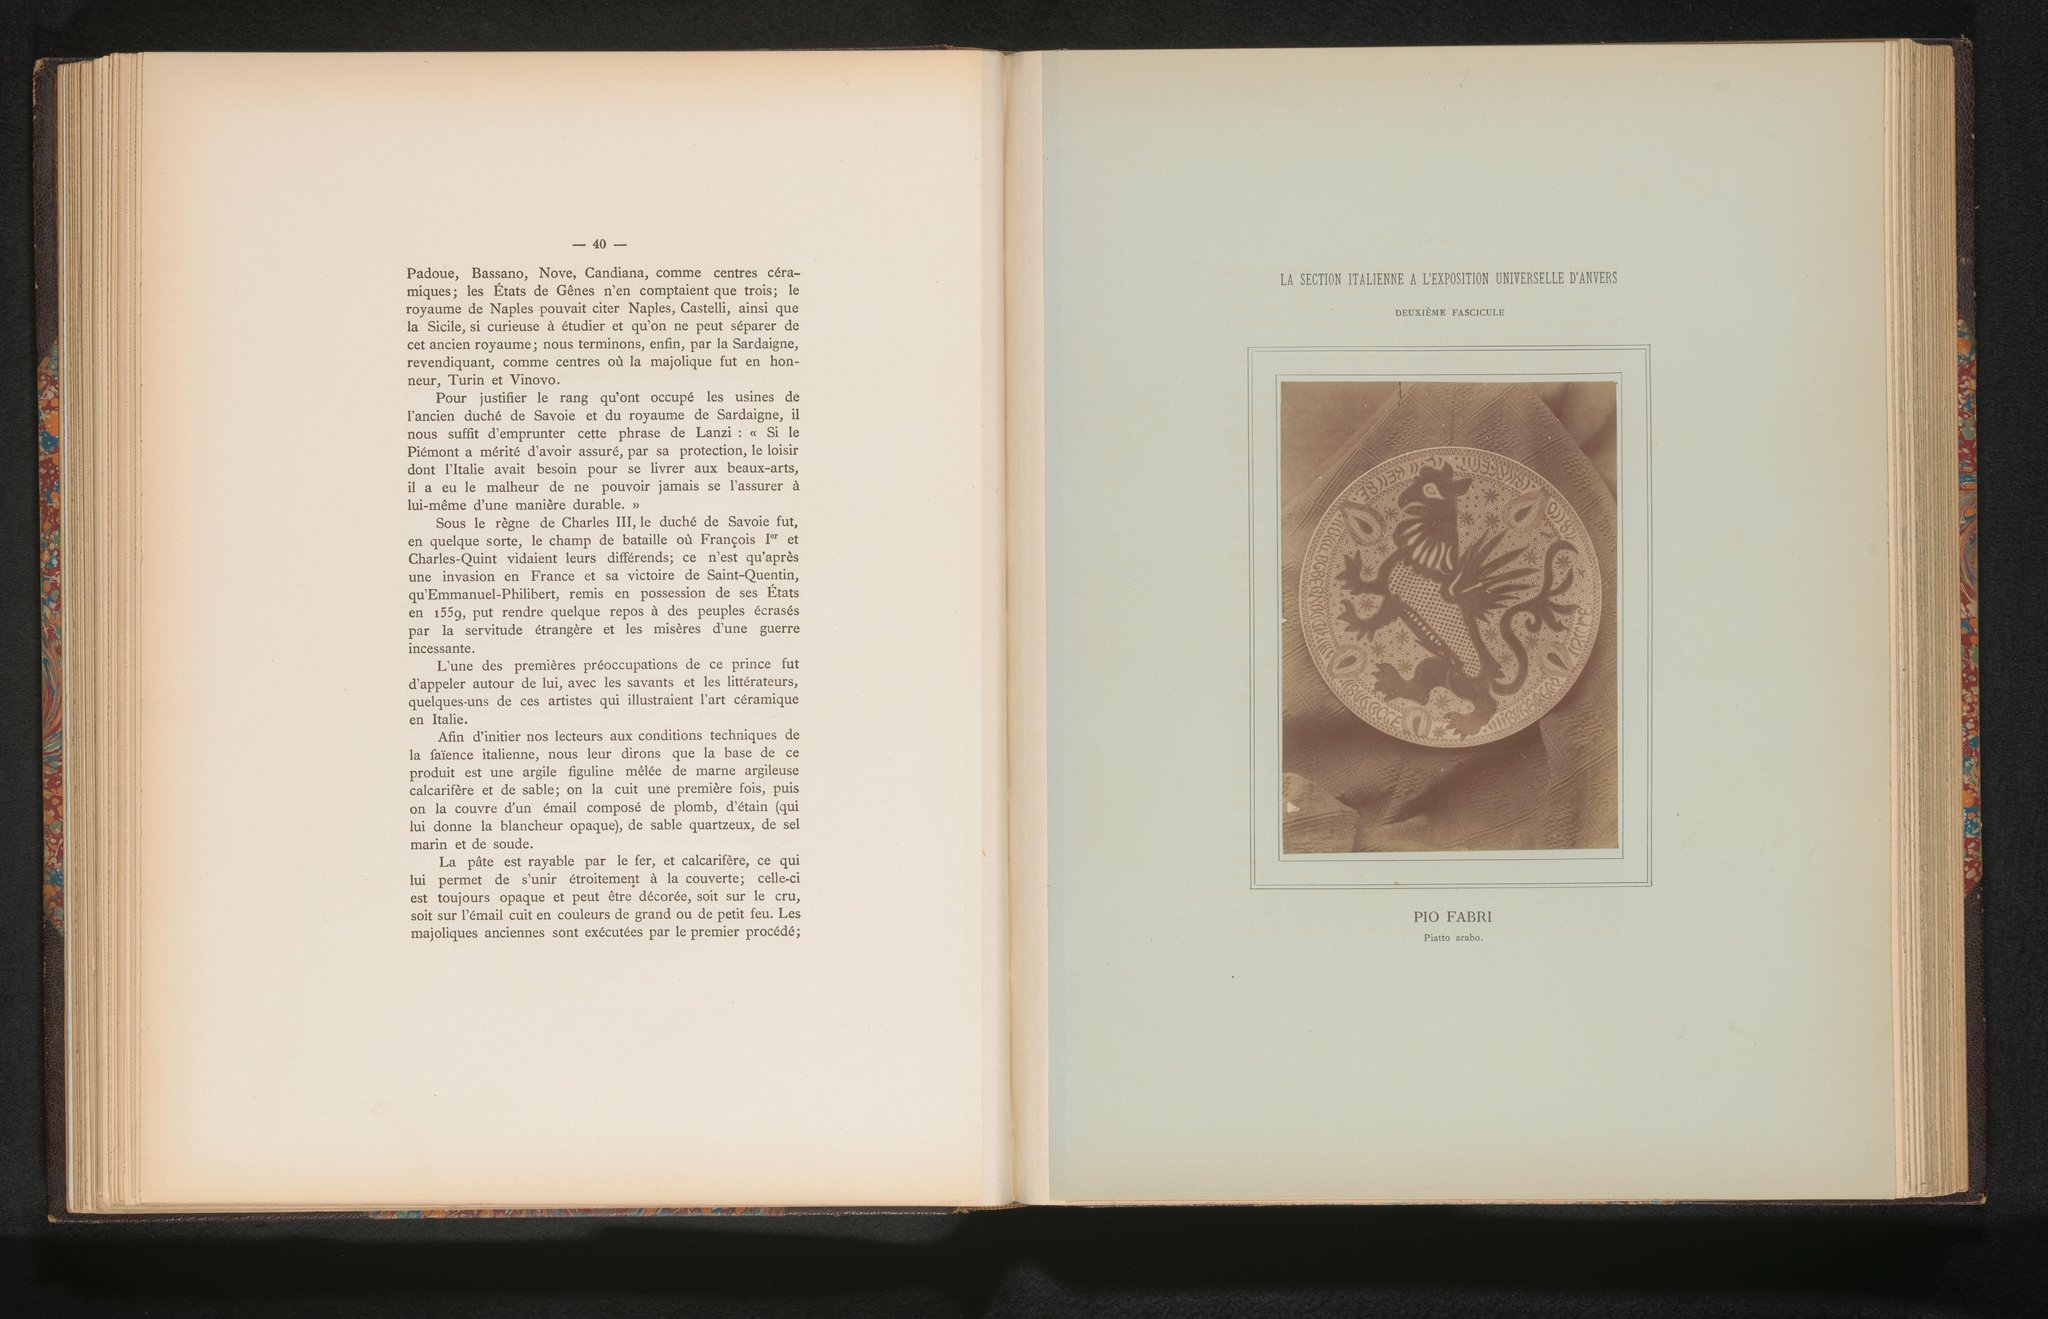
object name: photograph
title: Gedecoreerd servies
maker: Anonymous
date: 1880-1885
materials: photographic support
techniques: albumen print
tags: table-ware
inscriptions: inscription: ‘La section Italienne a l'exposition universelle d'Anvers/ premies fascicule’